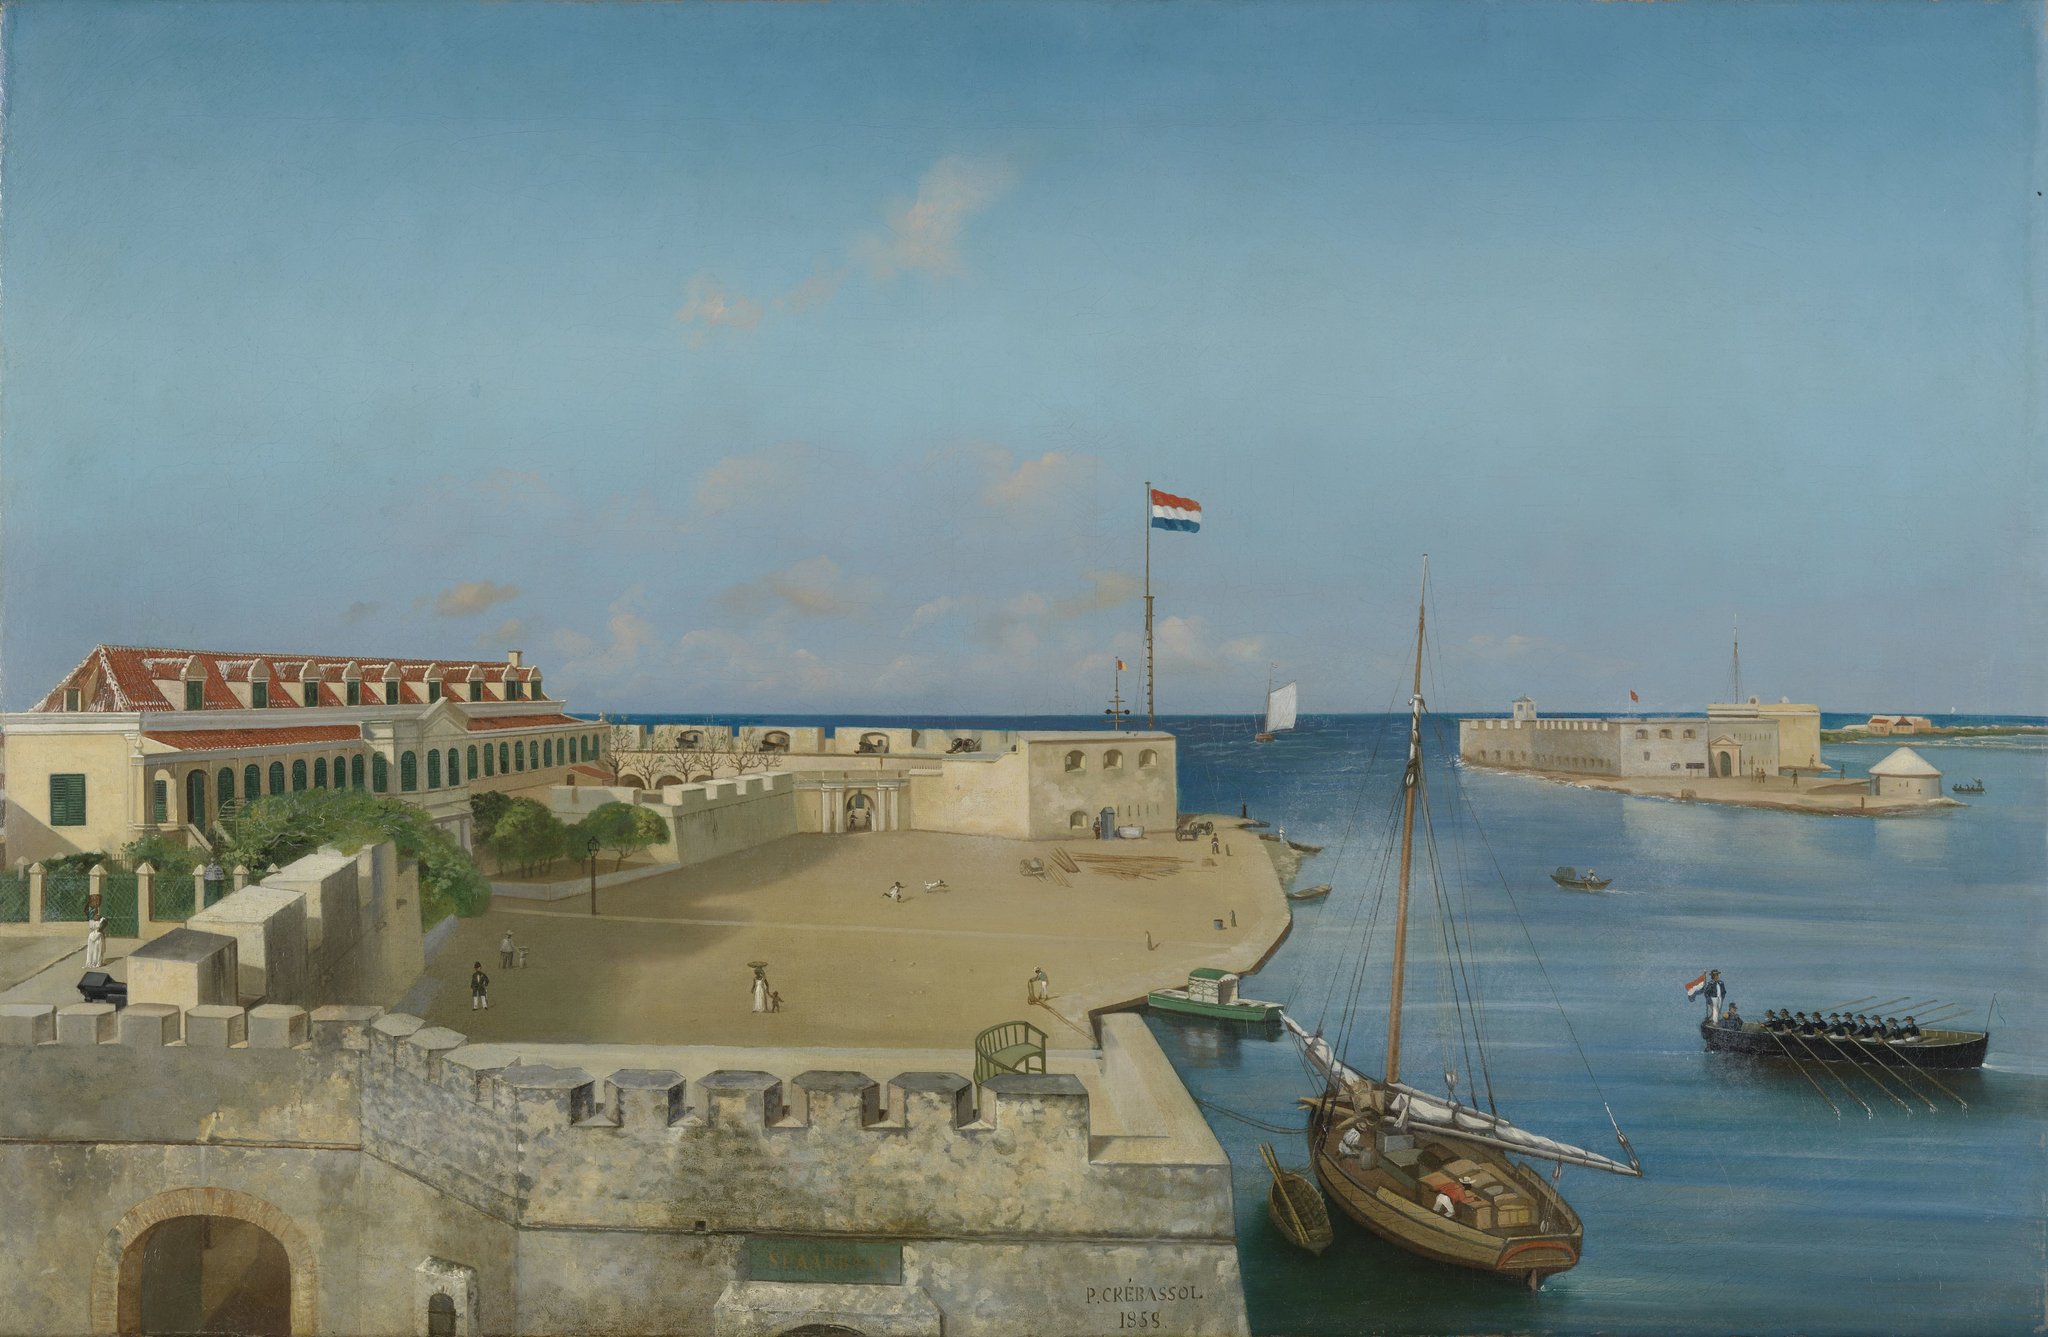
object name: painting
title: De haveningang van Willemstad met het Gouvernementspaleis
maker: prosper crébassol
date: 1858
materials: canvas, oil, paint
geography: willemstad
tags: harbour, warehouse (~ harbour)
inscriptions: signature and date: ‘P. Crebassol 1858’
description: Het schilderij toont de haveningang van Willemstad (het begin van de Sint Annabaai), gezien vanuit het drie verdiepingen hoge stadshuis annex pakhuis, gelegen op de hoek van de Handelskade en de Breedestraat. Links, tussen twee bolwerken van Fort Amsterdam, ligt het gouvernementshuis, de woning van de gouverneur. Tot 1861 was dit tevens de vergaderplaats van de Koloniale Raad en andere colleges. In het midden van het gouvernementshuis bevindt zich de poort die toegang geeft tot Fort Amsterdam. Midden op de achtergrond is het Waterfort te zien, voorzien van kanonnen, een vlaggenmast met de Nederlandse vlag en een optische telegraaf. Op de voorgrond het vroegere Waaggebouw, waarin sinds 1850 de Spaar- en Beleenbank is gevestigd. Boven de poort hangt een groen bord met opschrift: SPAARBANK. Deze poort geeft toegang tot het plein voor het gouvernementshuis. Op het plein zijn verschillende personen geschilderd. Vlakbij het wachthuisje van het Waterfort ligt een grote hoeveelheid hout naast een kar. Aan de waterkant zijn meerpalen te onderscheiden. Een open zeilschip beladen met handelswaar en een kleine sloep zijn afgemeerd aan de kade, evenals een kleine tentboot. Een barkas met tien roeiende matrozen en twee officieren is net van de kade vertrokken. Rechts op de achtergrond ligt het Riffort met een deel van het Rif, waarop het leprozenhuis staat. Het ronde gebouwtje voor het Riffort is het in 1831-1832 gebouwde spilhuisje met kaapstander, die diende om in tijden van oorlogsgevaar een ketting voor de ingang van de Sint Annabaai te spannen.